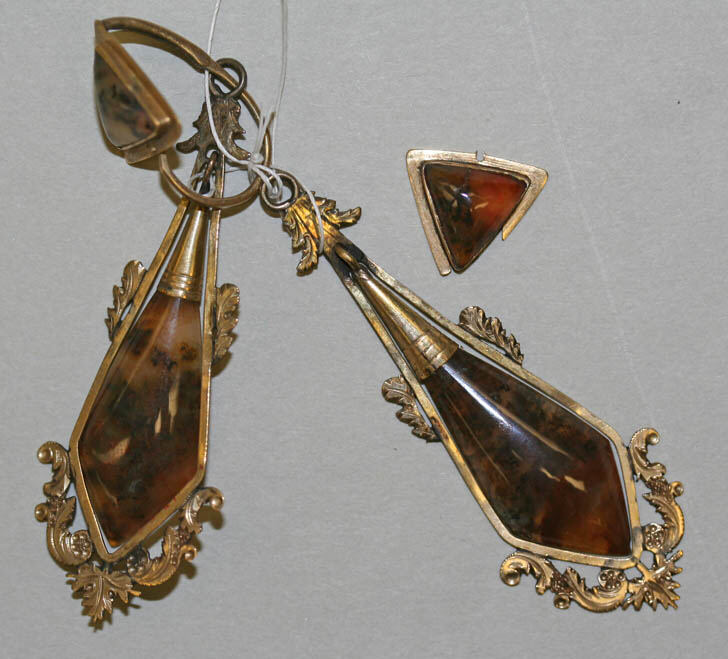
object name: earring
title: Earrings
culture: italian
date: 1801-1900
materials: gold, stone